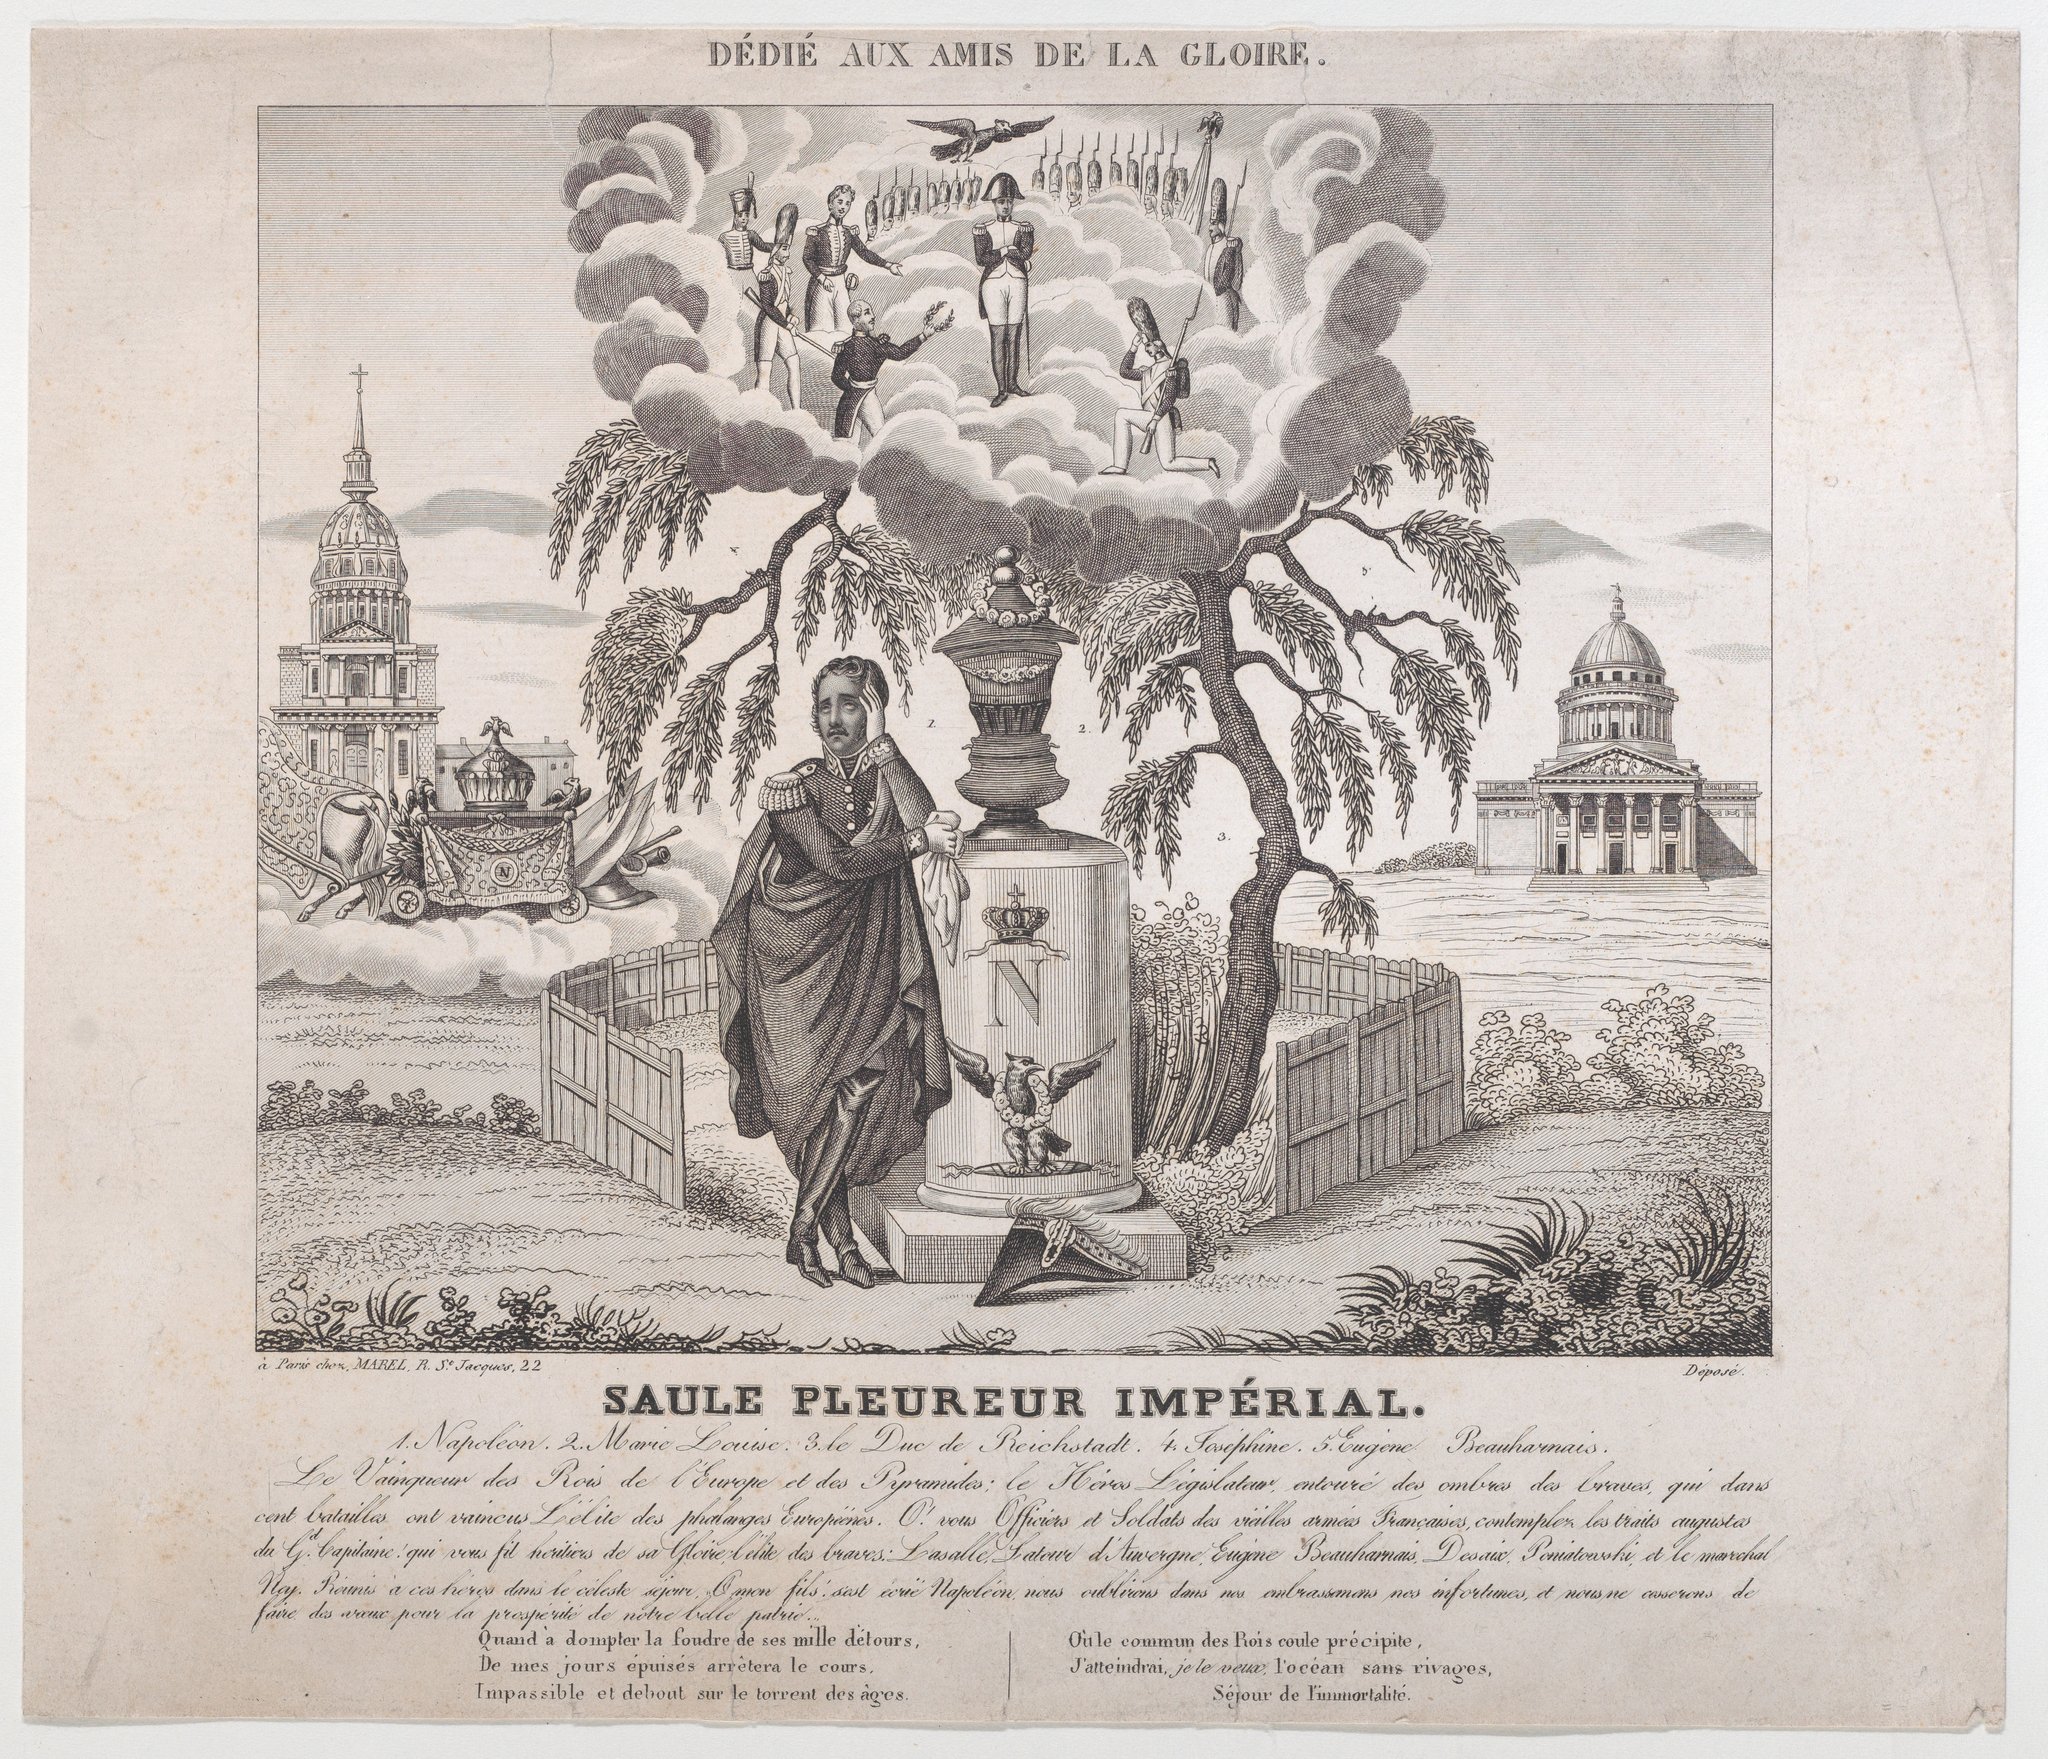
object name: print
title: Saule Pleureur Imperiale with hidden silhouettes of Napoleon and his family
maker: Anonymous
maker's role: artist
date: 1830-1850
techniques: engraving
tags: napoleon i,men,trees